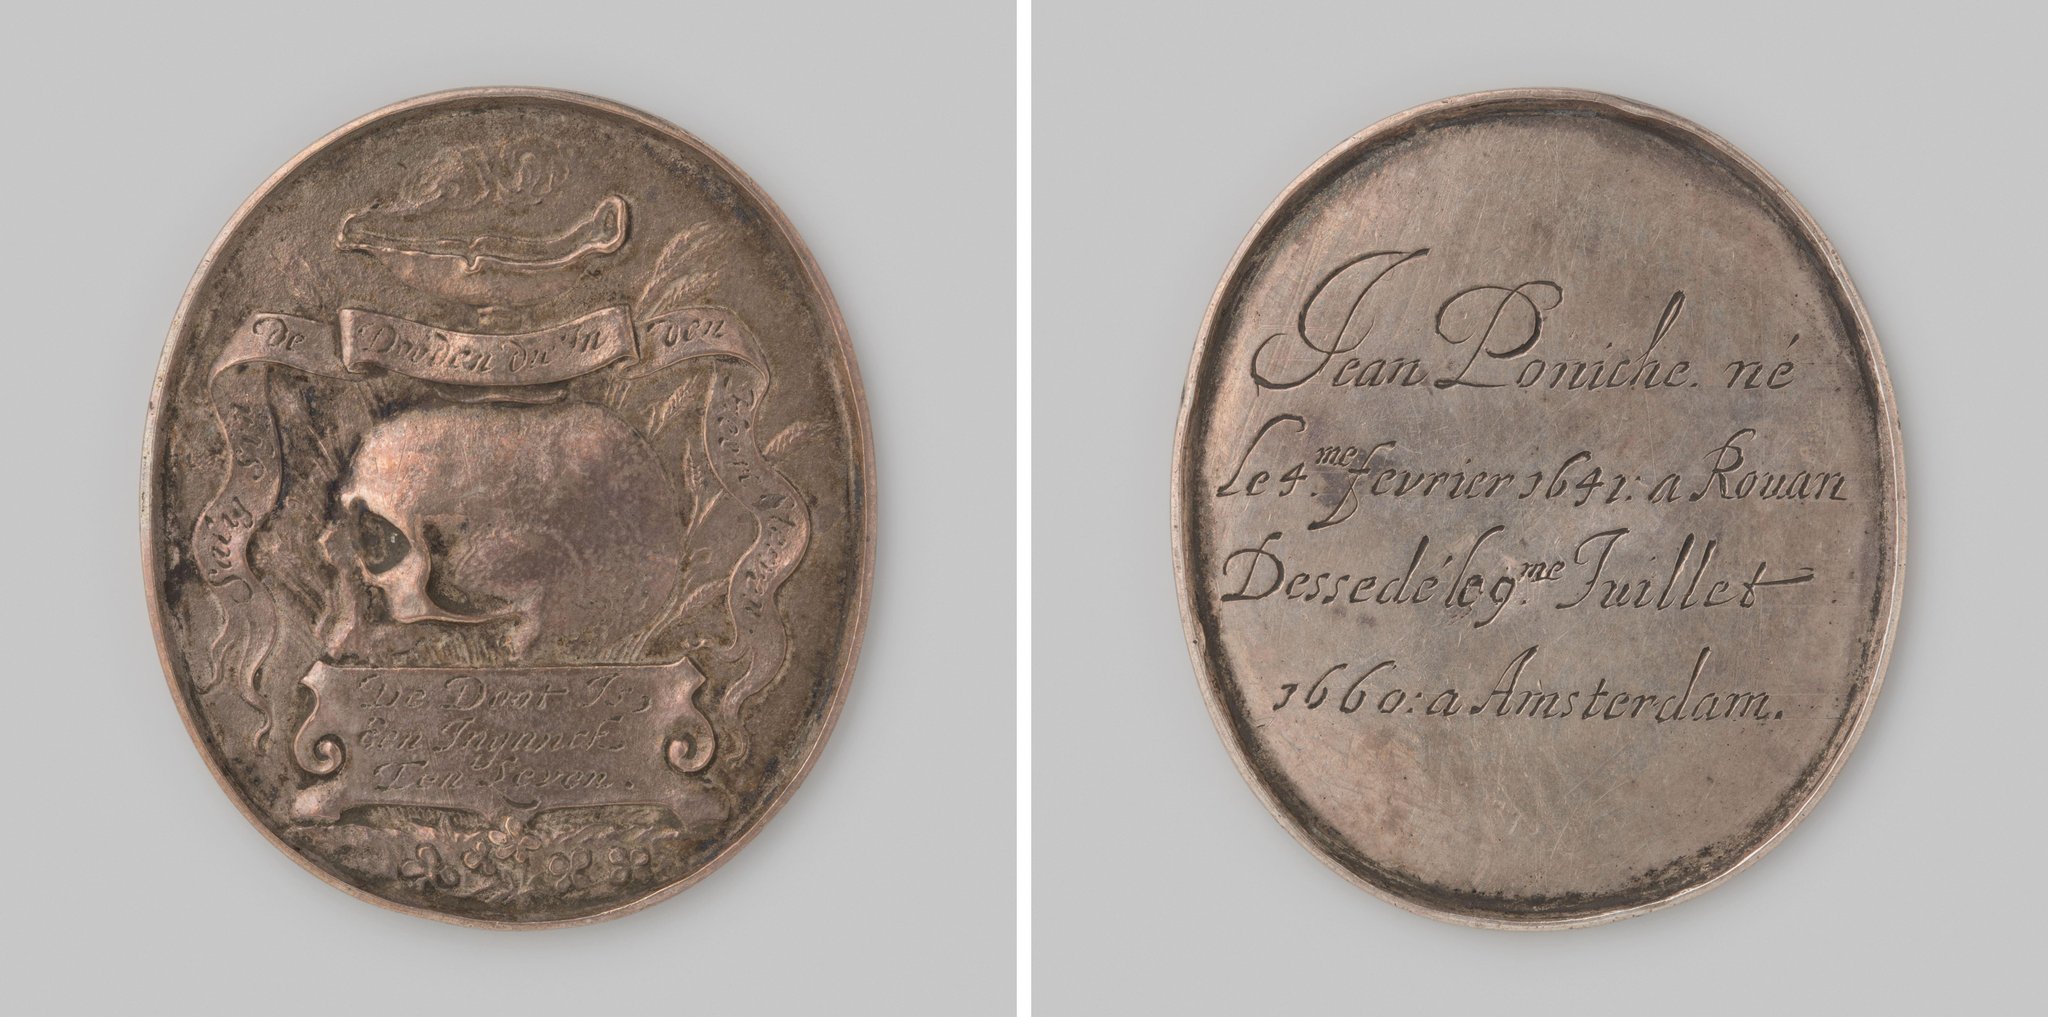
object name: history medal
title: Overlijden van Jean Poniche 1660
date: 1660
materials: silver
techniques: casting, engraving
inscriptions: inscription: ‘Jean Poniche né / le 4me fevrier 1641: a Rouan / Dessedé le 9me Juillet / 1660: a Amsterdam.’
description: Ovale zilveren penning, op de voorzijde een doodshoofd naar links waarboven een lint met opschrift, bovenaan een brandende olielamp, onderaan een tekstbord, op de blanco keerzijde een vierregelige inscriptie.